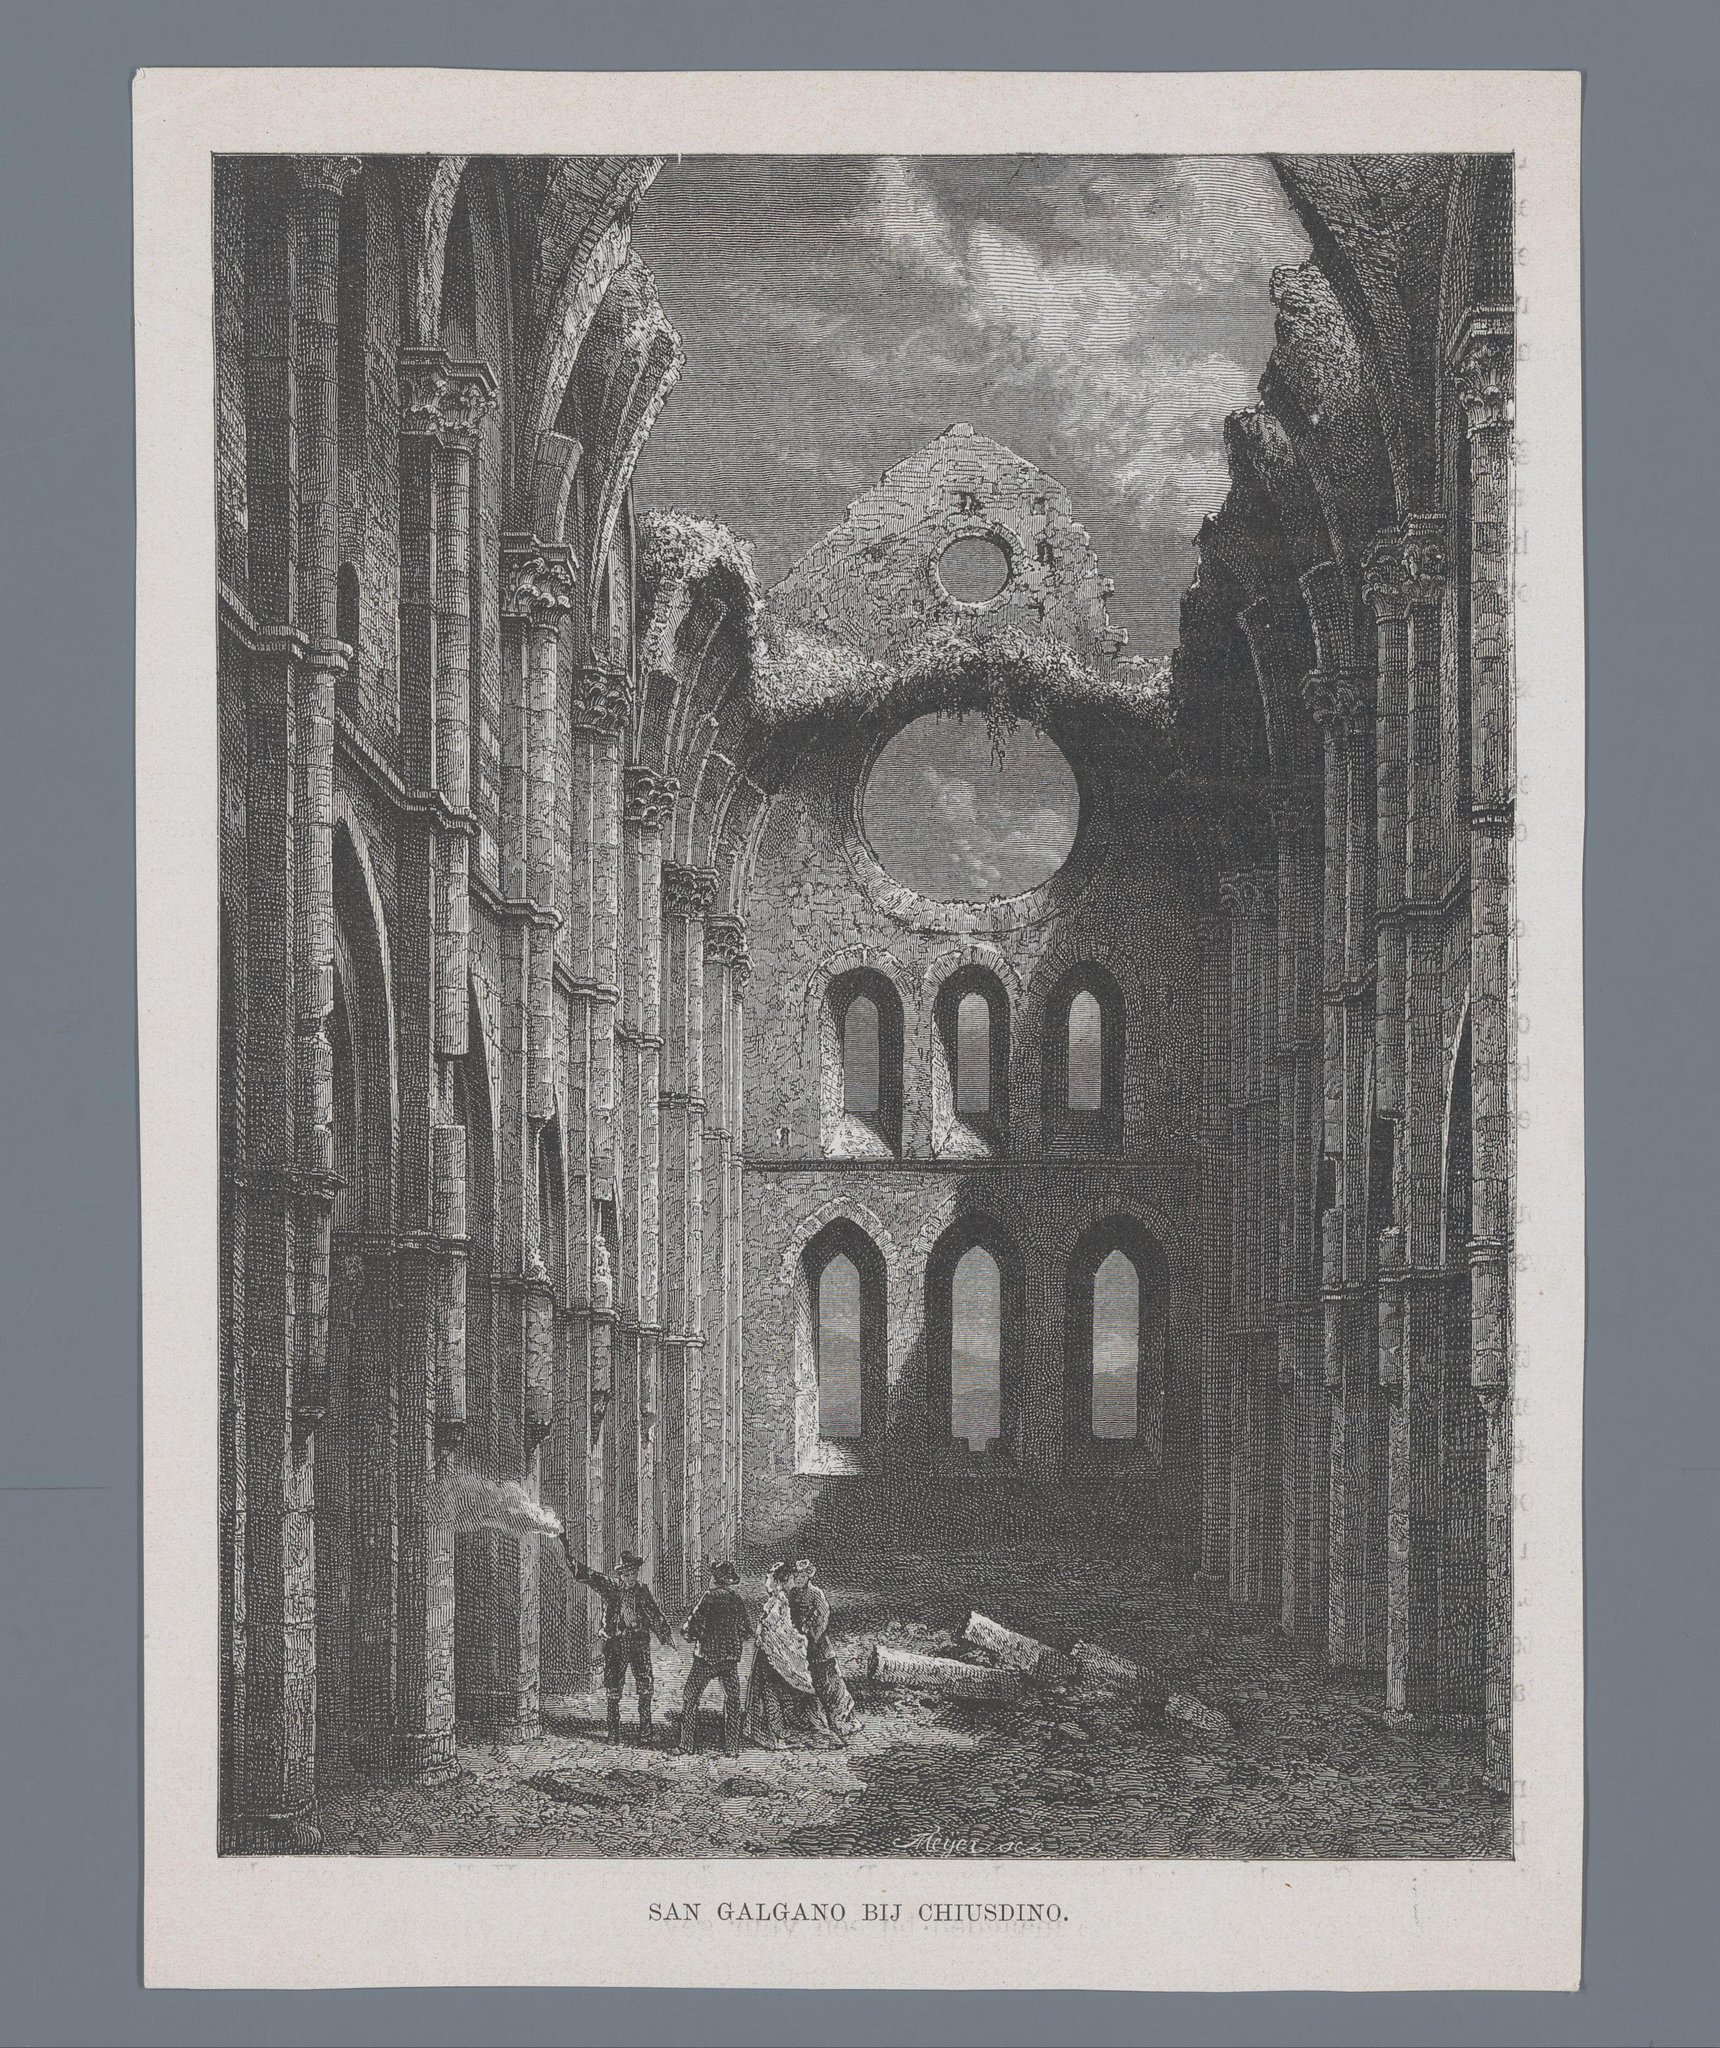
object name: book illustration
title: Gezicht op de abdij van San Galgano bij Chiusdino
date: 1880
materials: paper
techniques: letterpress printing, engraving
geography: leiden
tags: ruin of church, monastery, etc., roman catholic church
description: Prent uit: Keller, Gerard. Italië: van de Alpen tot de Etna. Leiden: Sijthoff, 1880.